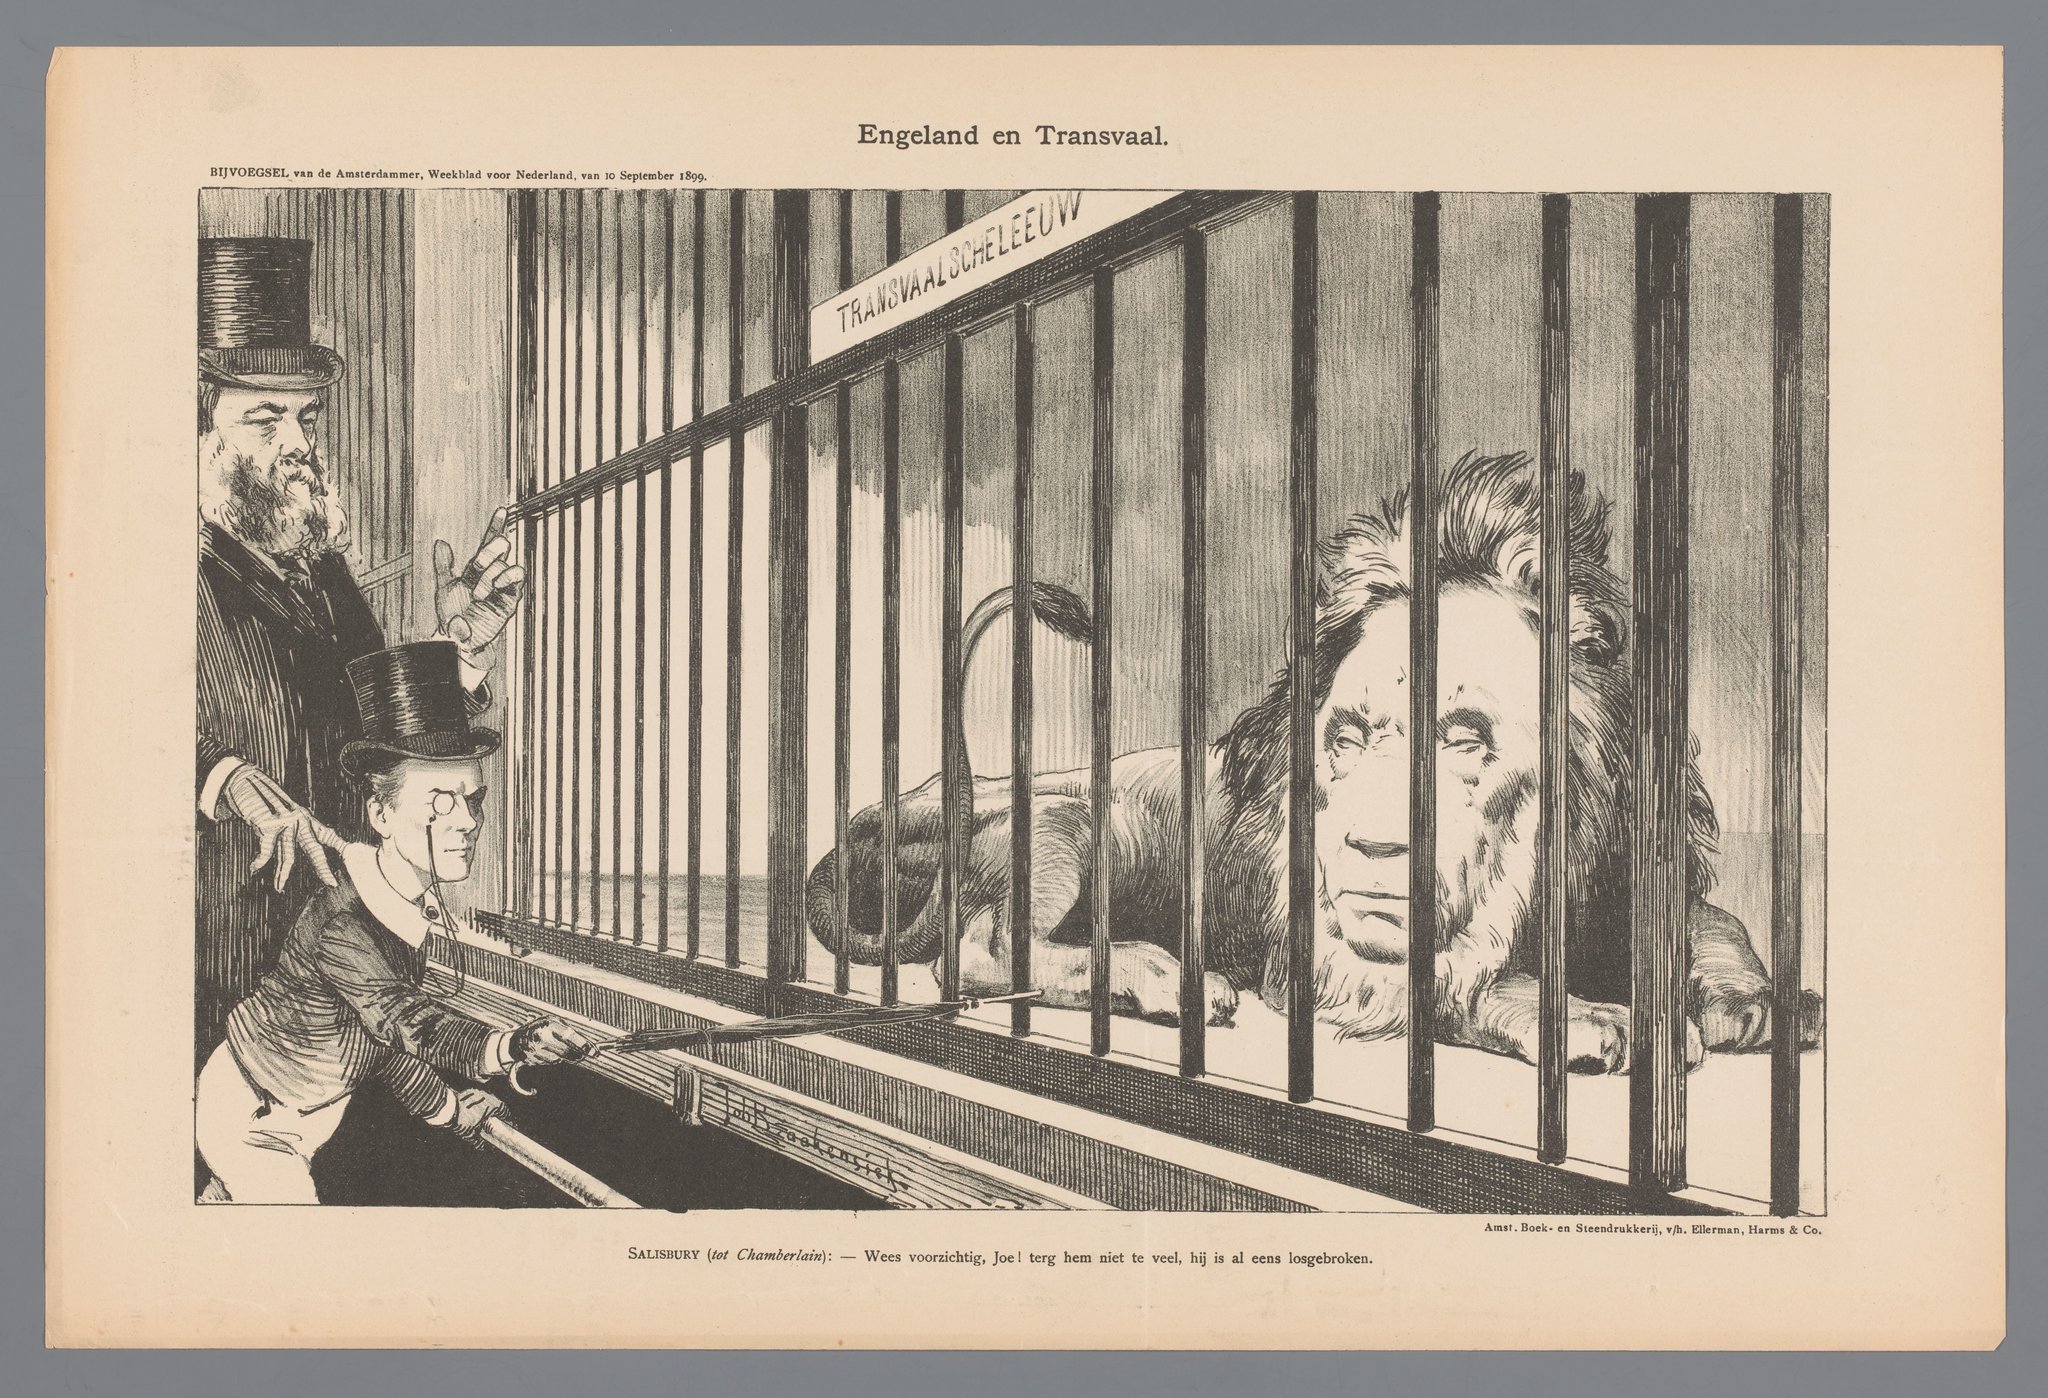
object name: cartoon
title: Engeland en Transvaal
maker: johan braakensiek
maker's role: draughtsman, print maker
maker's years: 1858-1940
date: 1899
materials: paper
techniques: lithograph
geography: amsterdam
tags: politician, historical persons, beasts of prey, predatory animals: lion, political caricatures and satires, zoo (as place of recreation)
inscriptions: date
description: Prent uit het bijvoegsel van: De Amsterdammer. Weekblad voor Nederland, 10 september 1899.